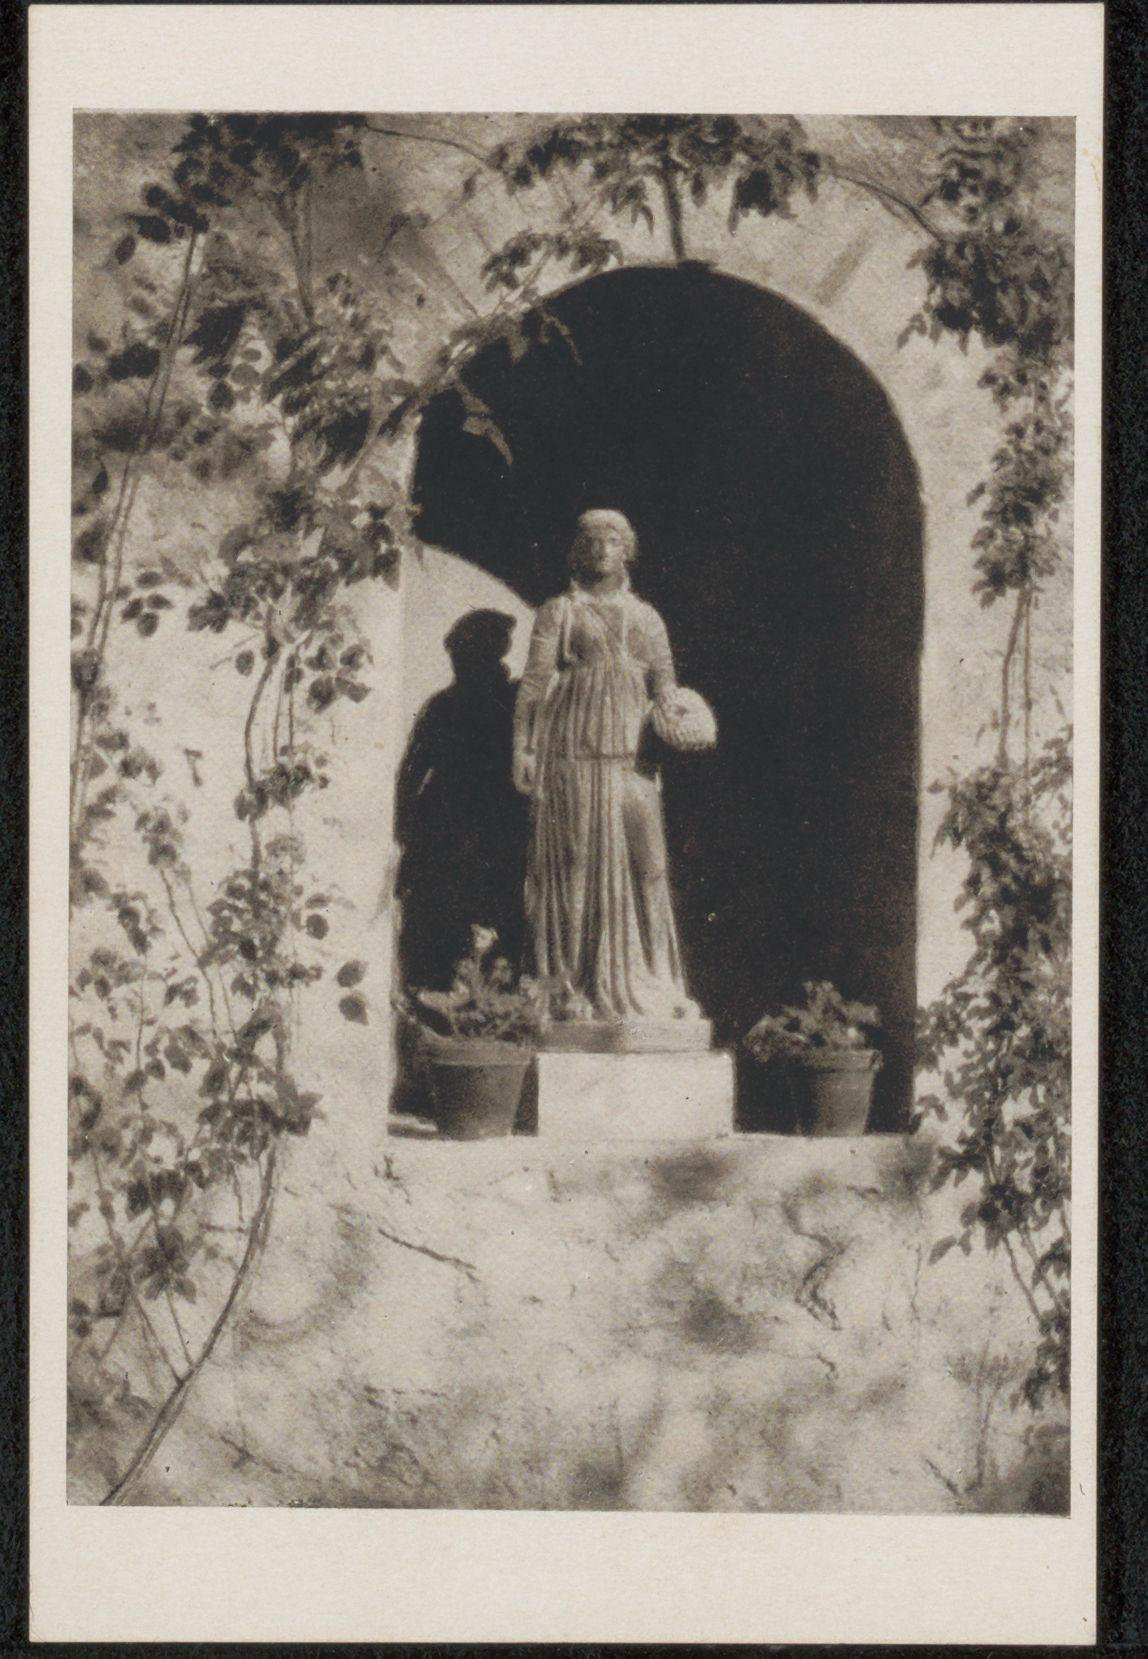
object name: ansichtkaart, prentbriefkaart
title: Prentbriefkaart aan Philip Zilcken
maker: ferdinand-sigismund bac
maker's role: draughtsman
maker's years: 1859-1952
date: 1927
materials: cardboard, ink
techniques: pen, writing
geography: menton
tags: the hague, draughtsman, philip zilcken, netherlands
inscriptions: collector's mark: ‘RPK’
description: Bevat twee onbeschreven prentbriefkaarten. De drie kaarten betreffen fotoreproducties van de villa Les Colombières. Ferdinand Bac ontwierp de tuinen van de villa. Ook ontwierp hij delen van het interieur en voerde deze ontwerpen uit.